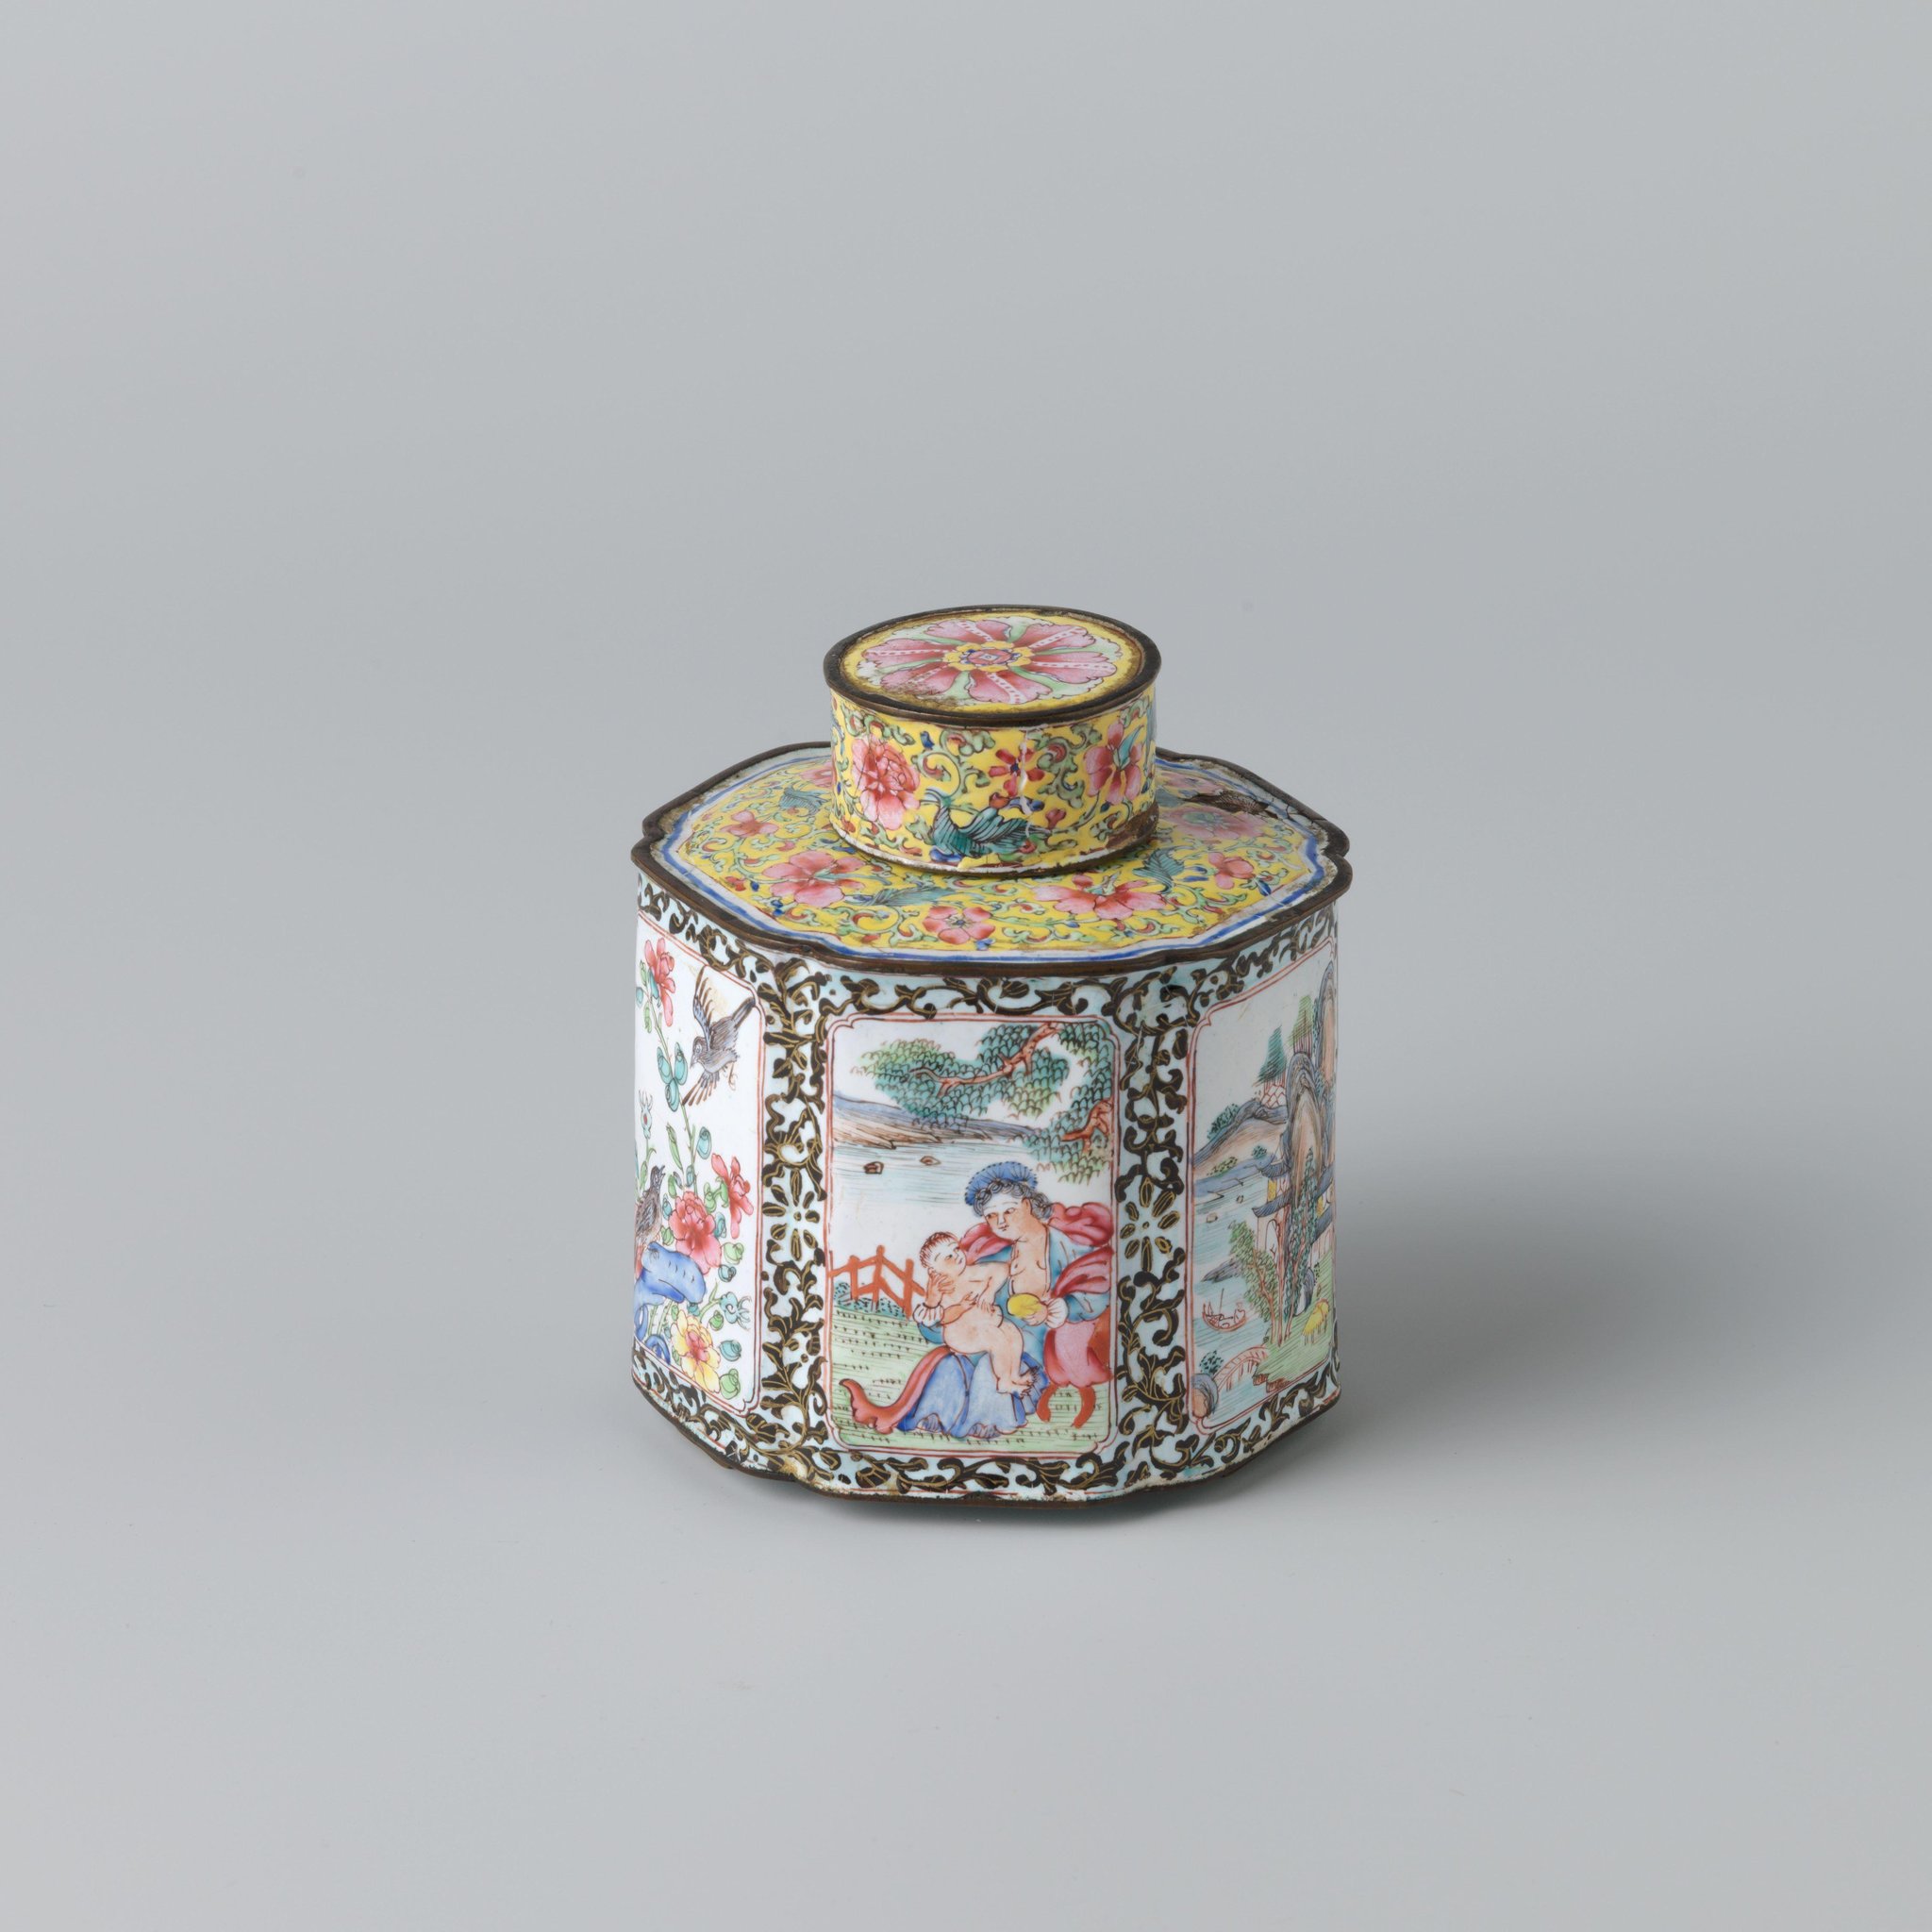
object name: tea caddy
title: Zeshoekige theebus, geschilderd email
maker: Anonymous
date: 1740-1760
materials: copper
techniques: enamel painting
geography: china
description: Zeskantige theebus met ingenepen hoeken op drie zeer lage ongeglazuurde pootjes en met vlakke schouders en ronde, vlakke dop. Op de zes zijden drie verschillende voorstellingen, geschilderd in roze, blauw, groen (2 tinten), bruin, oranje en geel email: een waterlandschap, twee vogels bij bloeiende planten en een rots, een vrouw met ontblote borst en een kind op schoot bij de waterkant (Maria?). Tussen de velden zwarte ranken met gouden details op een zeer lichtblauwe ondergrond. Op de bodem een Europese bloemrank in blauw.